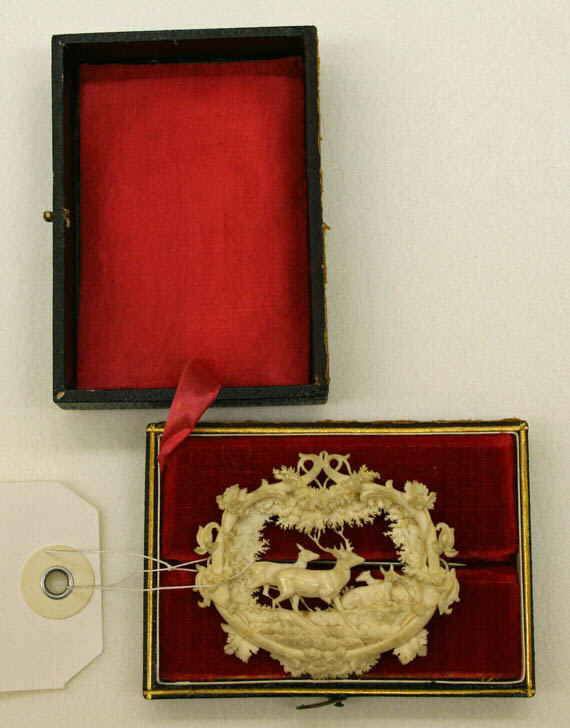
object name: brooch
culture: german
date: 1870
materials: ivory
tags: deer